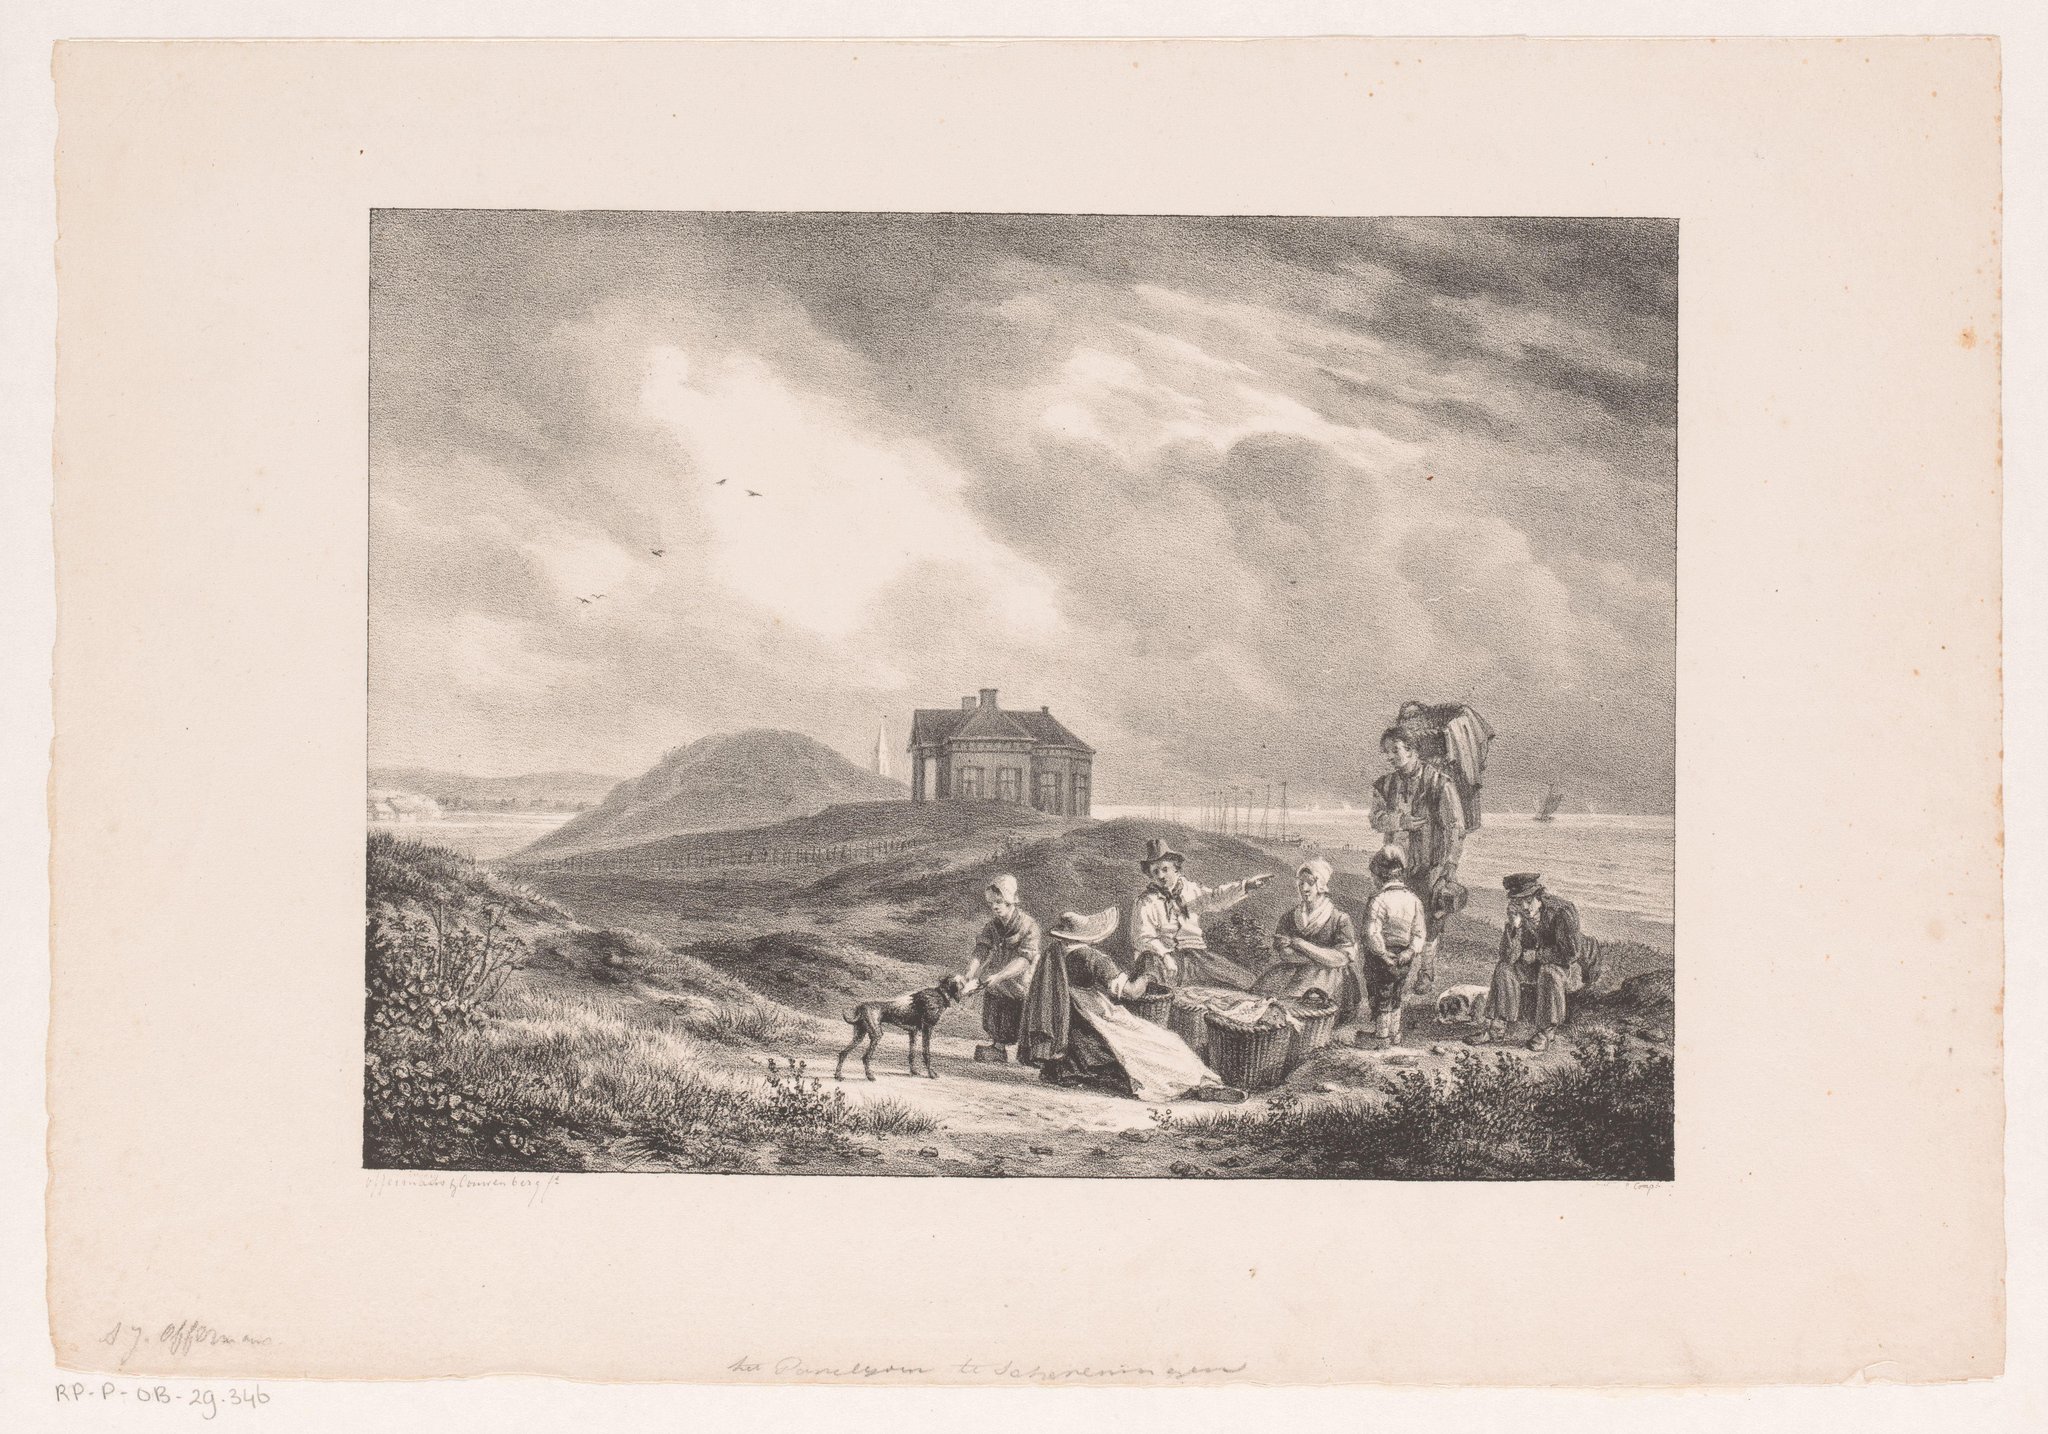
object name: print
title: Vissers in de Scheveningse duinen nabij paviljoen Von Wied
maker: abraham johannes couwenberg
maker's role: draughtsman, print maker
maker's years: 1806-1844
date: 1809-1844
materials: paper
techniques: lithograph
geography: netherlands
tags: dune coast, family group, especially parents with their child(ren)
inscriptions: inscription: ‘[Couwen]berg [...] & Comp’, collector's mark: Lugt 2228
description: Een gezelschap van mannen, vrouwen, kinderen en een hond met manden met vis op een duin ten noorden van het Koninklijk Paviljoen (later Paviljoen Von Wied) te Scheveningen. In de achtergrond het paviljoen en boten op zee.